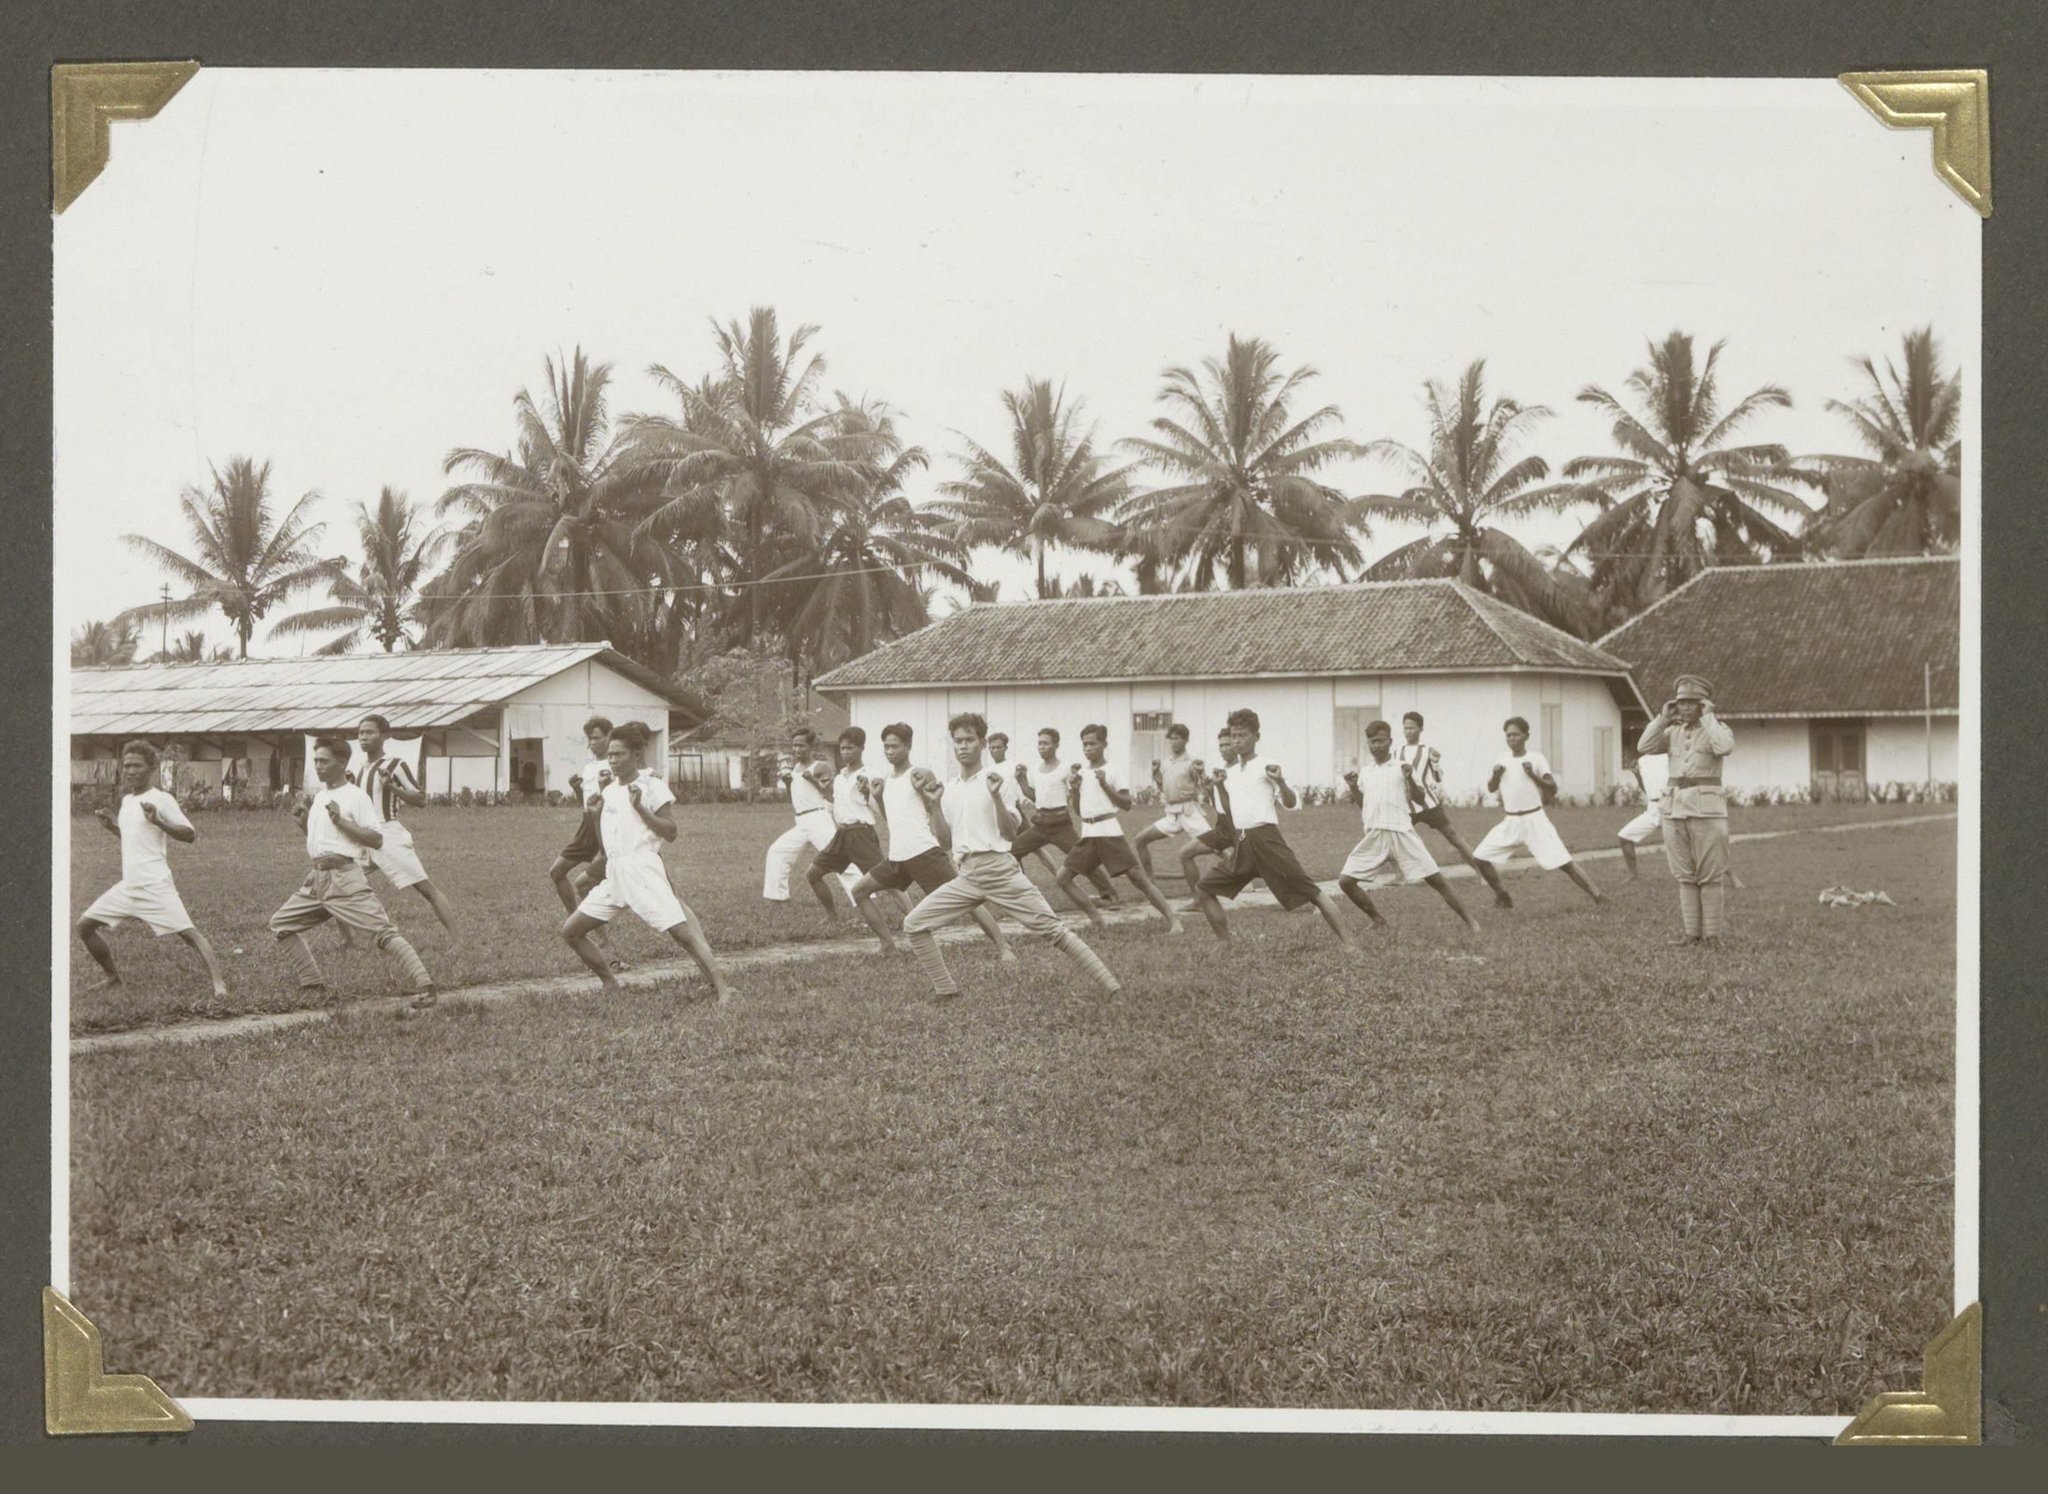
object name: photograph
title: Politieagenten in Lampong tijdens een gymnastiekles in de buitenlucht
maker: Anonymous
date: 1932-1933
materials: photographic support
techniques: gelatin silver print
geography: lampung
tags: gymnastic exercises on the ground, police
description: Onderdeel van Herinneringsalbum voor F.J. Junius, vertrekkend resident van Lampong (Zuid-Sumatra).